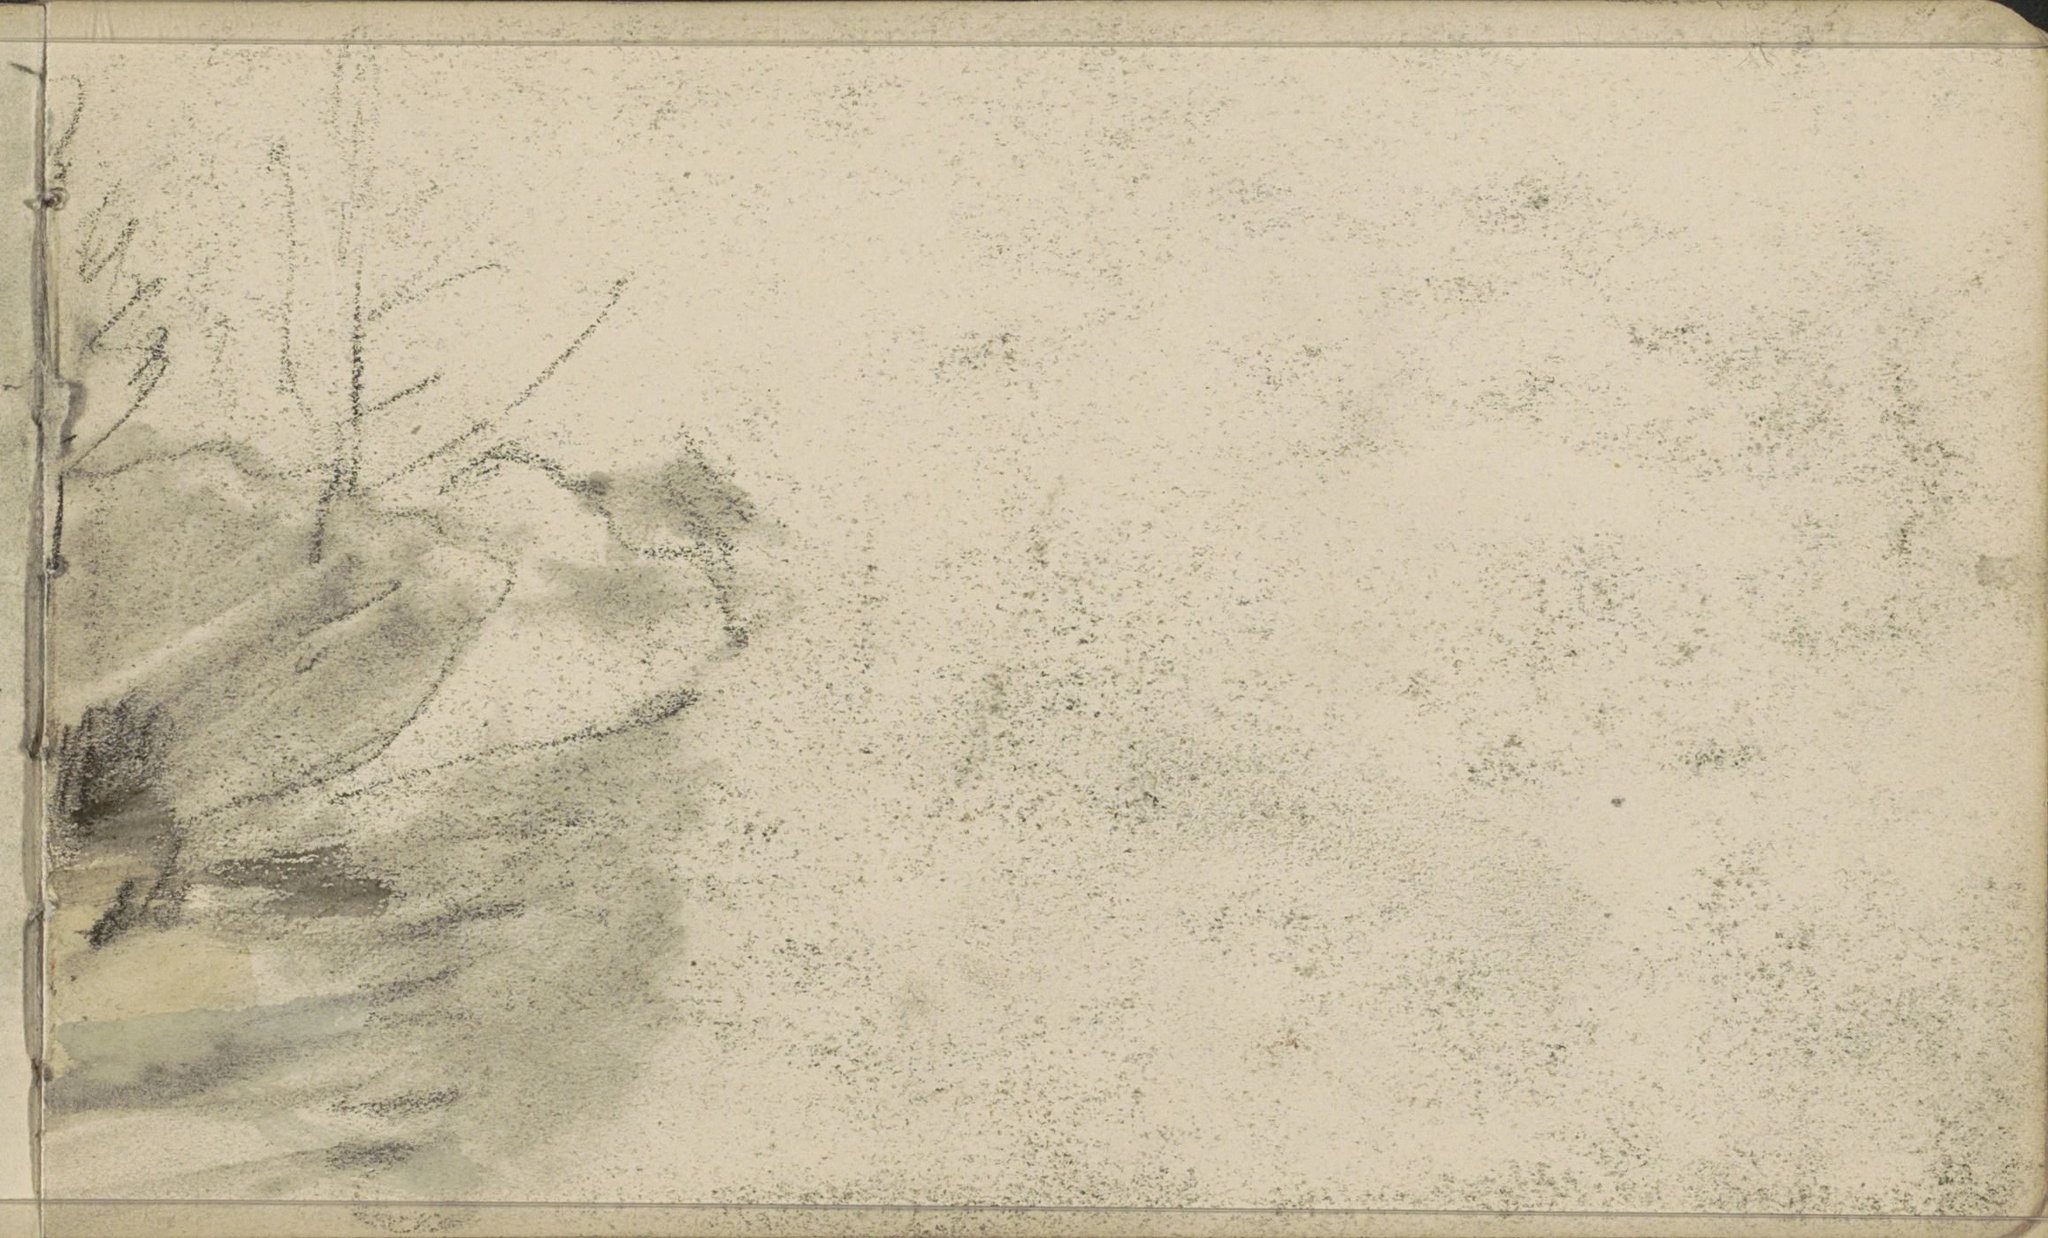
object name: sketchbook leaf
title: Landschap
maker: johan antonie de jonge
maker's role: draughtsman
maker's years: 1864-1927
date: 1881-1927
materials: chalk, paper, watercolor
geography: south holland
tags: landscapes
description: Landschap. Blad 4 uit een schetsboek met 34 bladen.